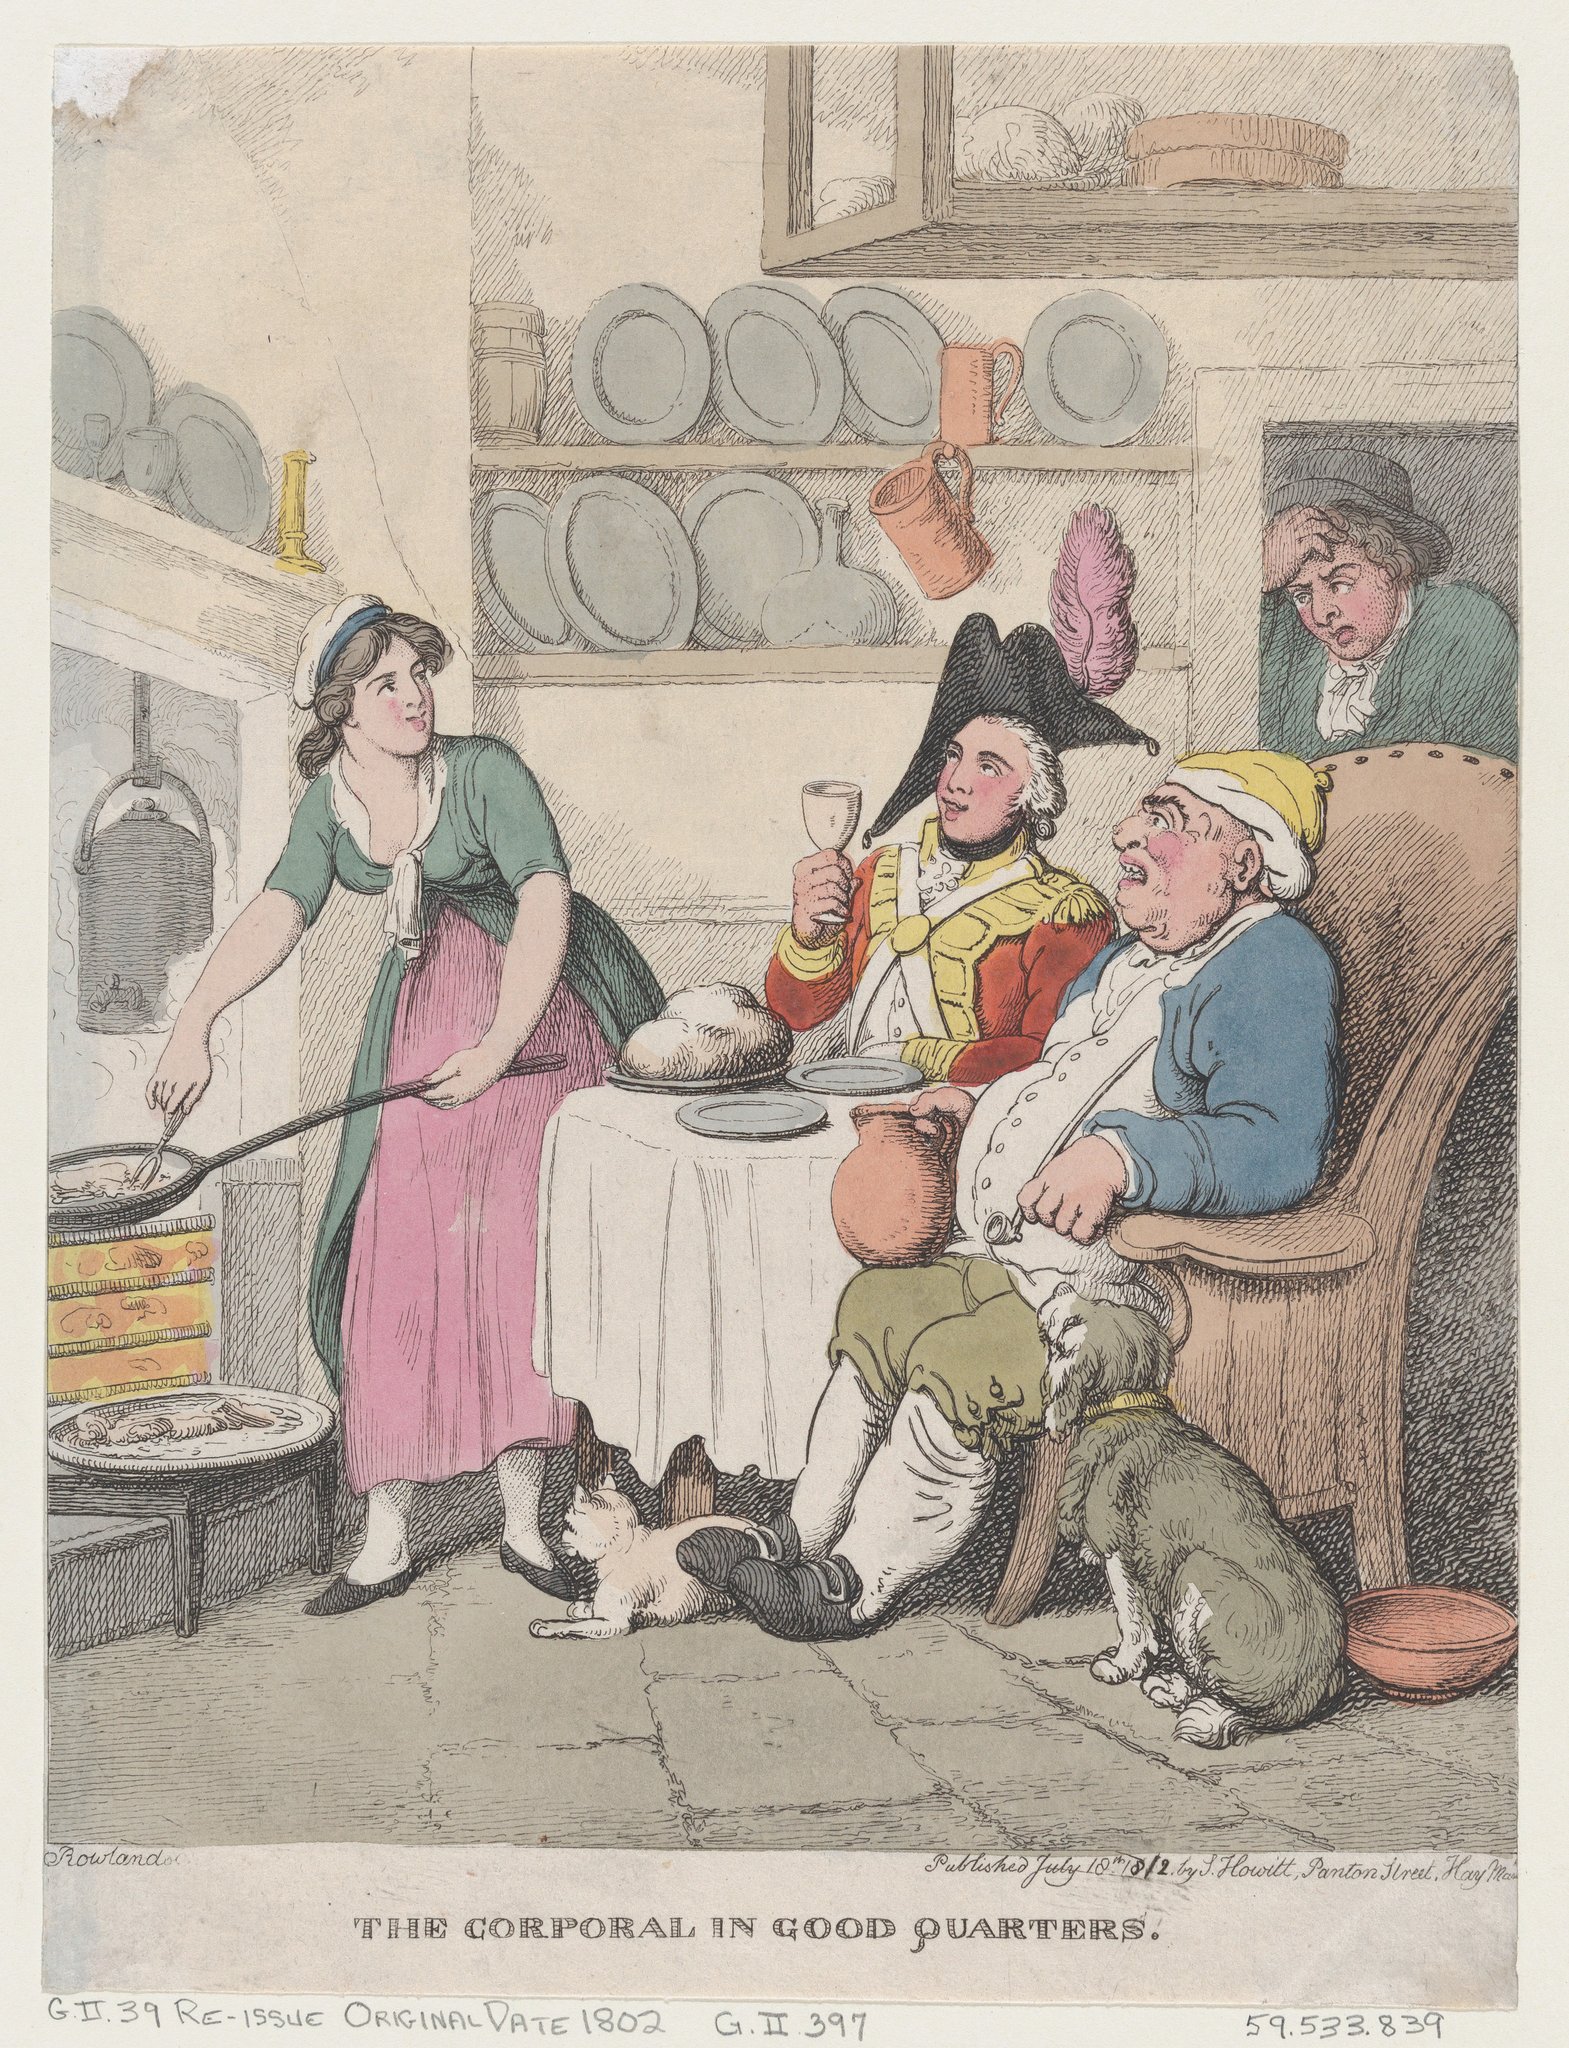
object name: print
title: The Corporal in Good Quarters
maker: thomas rowlandson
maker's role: artist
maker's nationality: british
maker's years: 1757-1827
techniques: etching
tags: food,men,women,cats,dogs